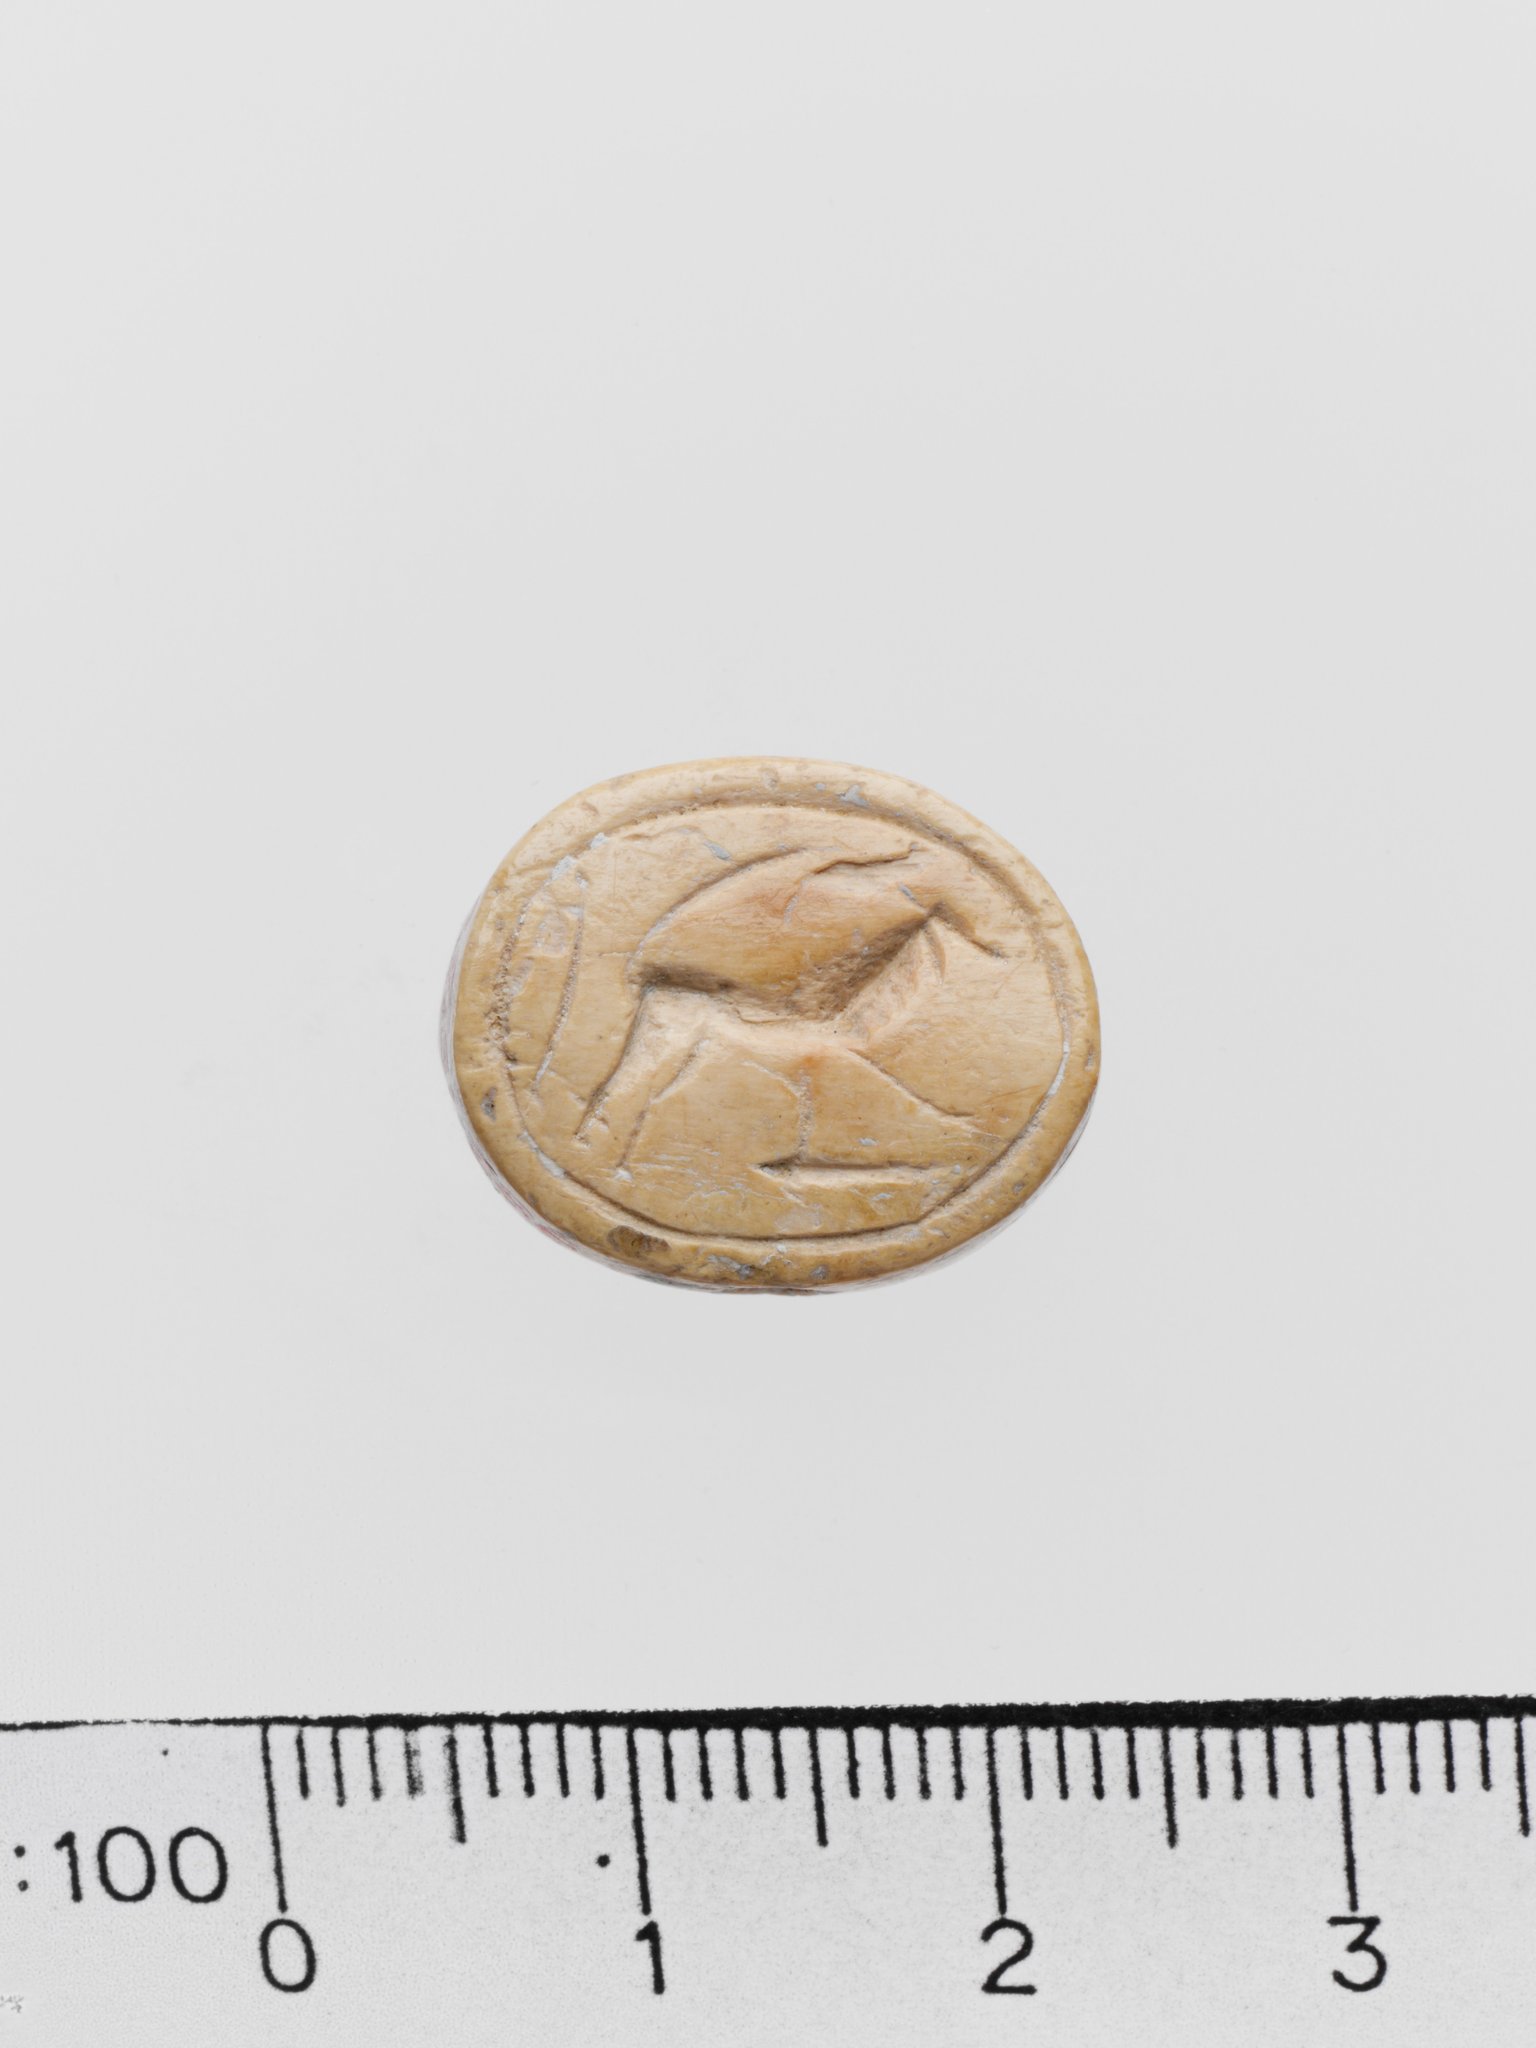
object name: seal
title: Ivory elliptical-shaped seal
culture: minoan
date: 1900-1750 BCE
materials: bone